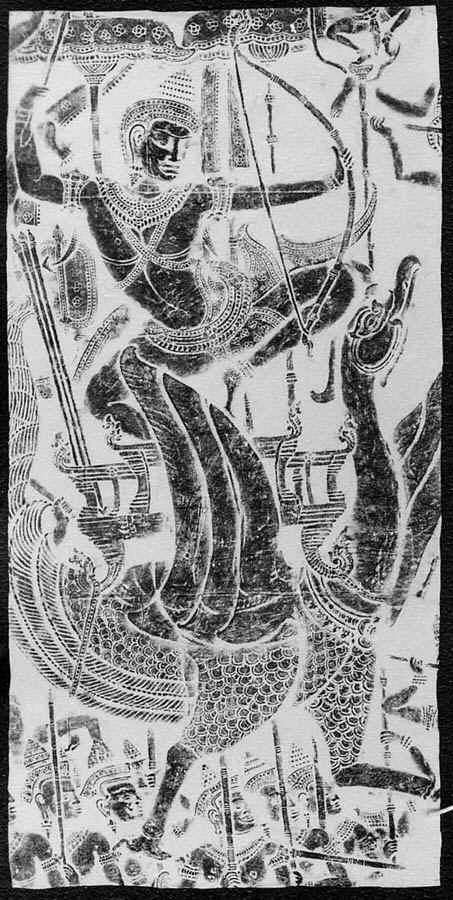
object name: rubbing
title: Rubbing of a Figure of Skanda, the God of War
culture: cambodian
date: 1901-2000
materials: ink, paper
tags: birds,bow and arrow,men